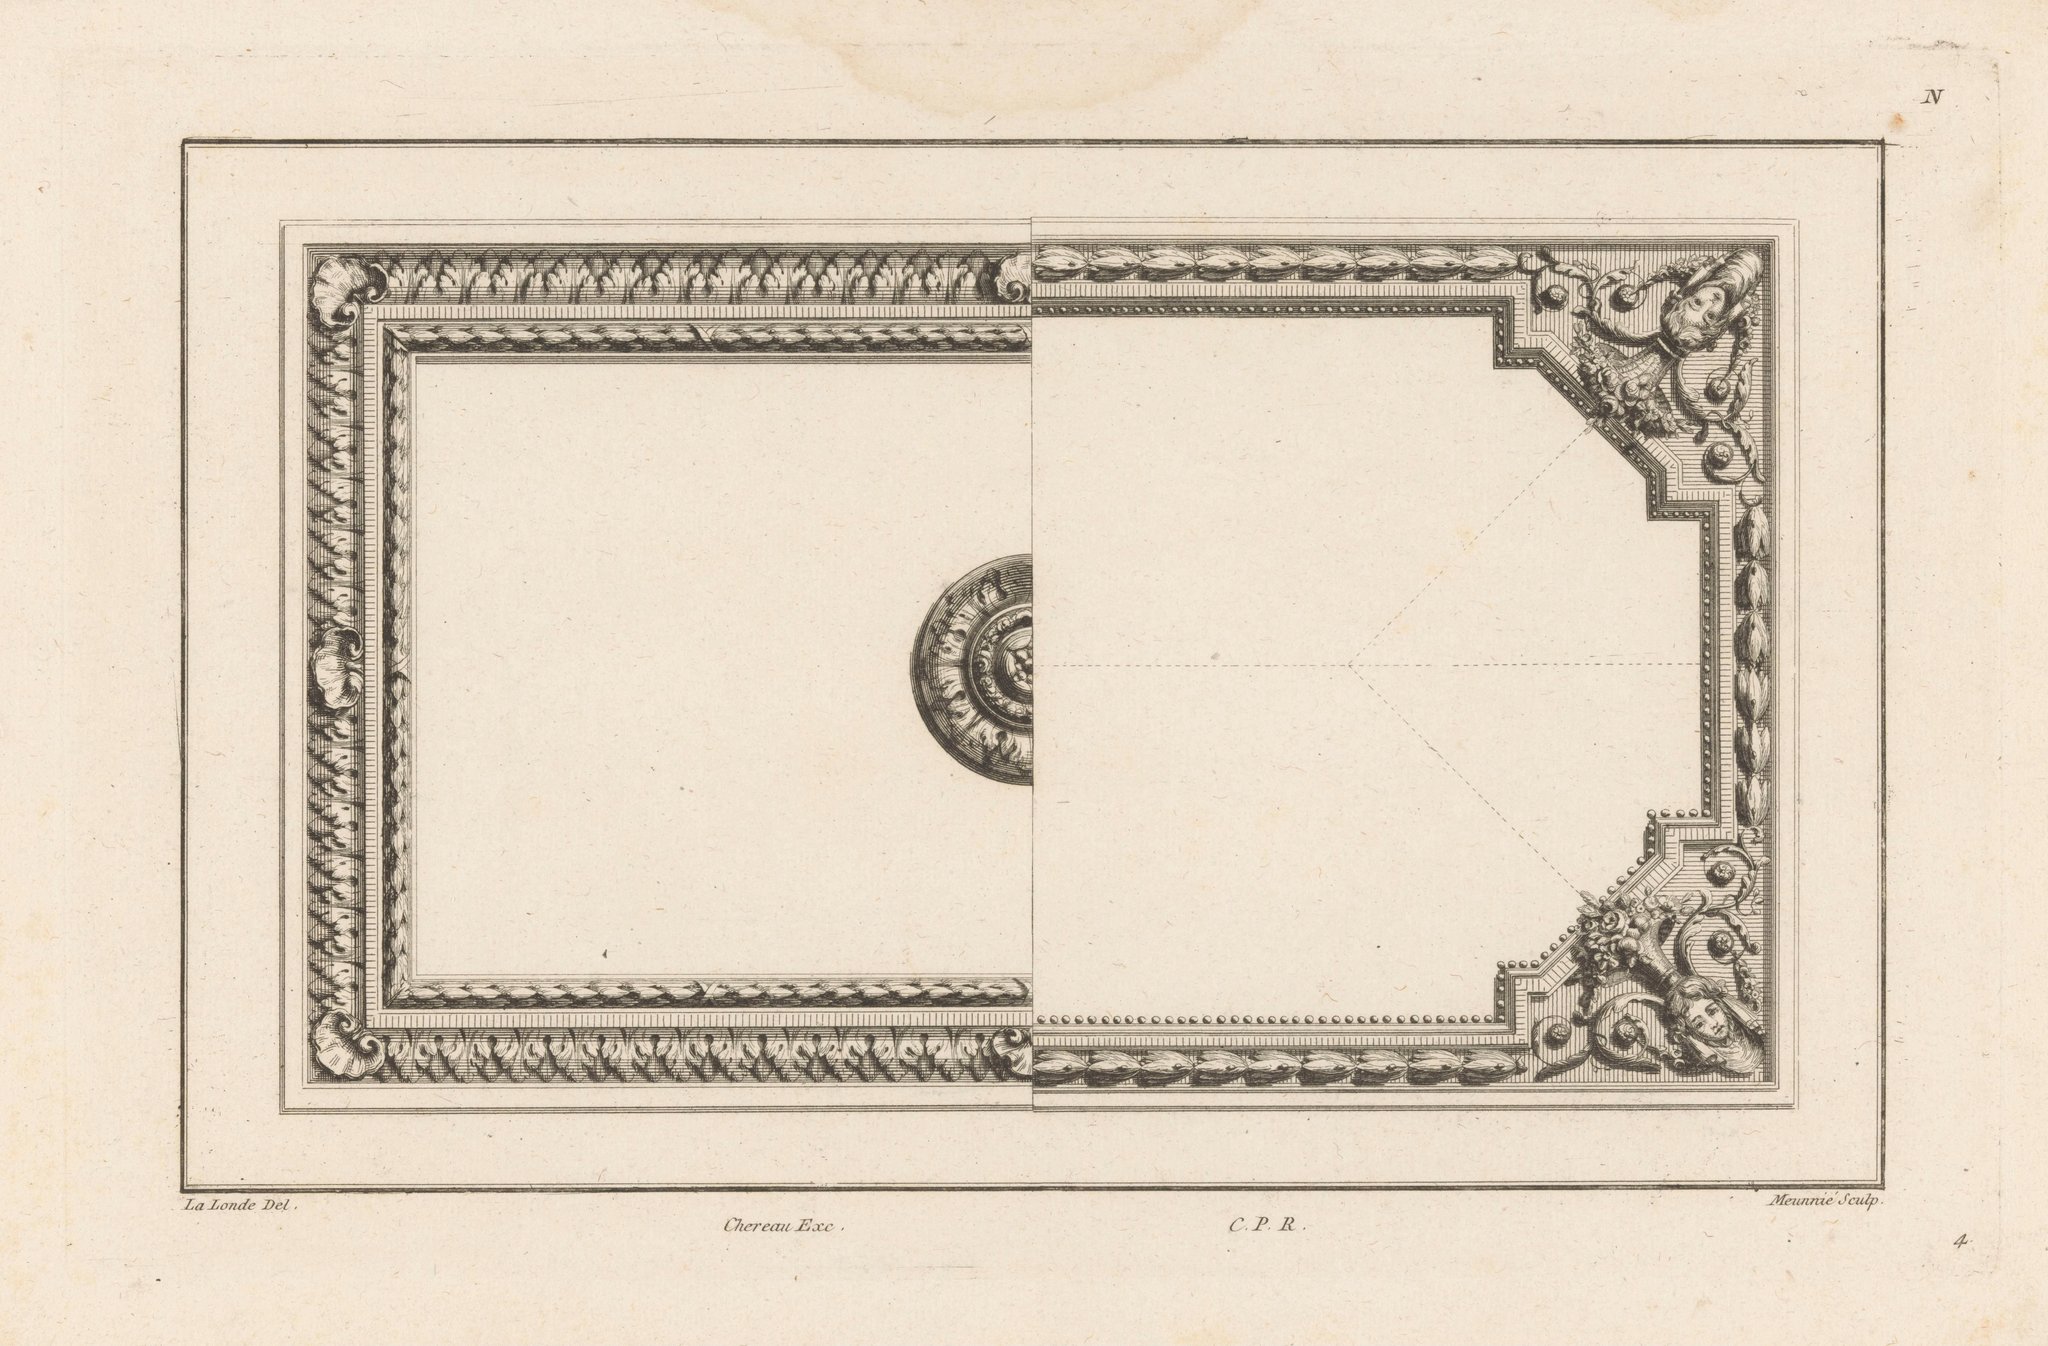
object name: ornament print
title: XIIIe Cahier de l'Oeuvre de La Londe N Plafonds de diverses formes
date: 1784-1785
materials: paper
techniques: engraving, etching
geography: paris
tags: rosette ~ ornament, (decorated) ceiling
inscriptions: collector's mark: Lugt 2228, collector's mark: Lugt 2760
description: Een rechthoekig geornamenteerd plafond met een rand van acanthusbladeren, schelpmotieven en bloemmotieven. In het midden een rozet. Rechts in de hoeken vrouwenhoofden met bloemenvazen op het hoofd omgeven door vlechtwerk.